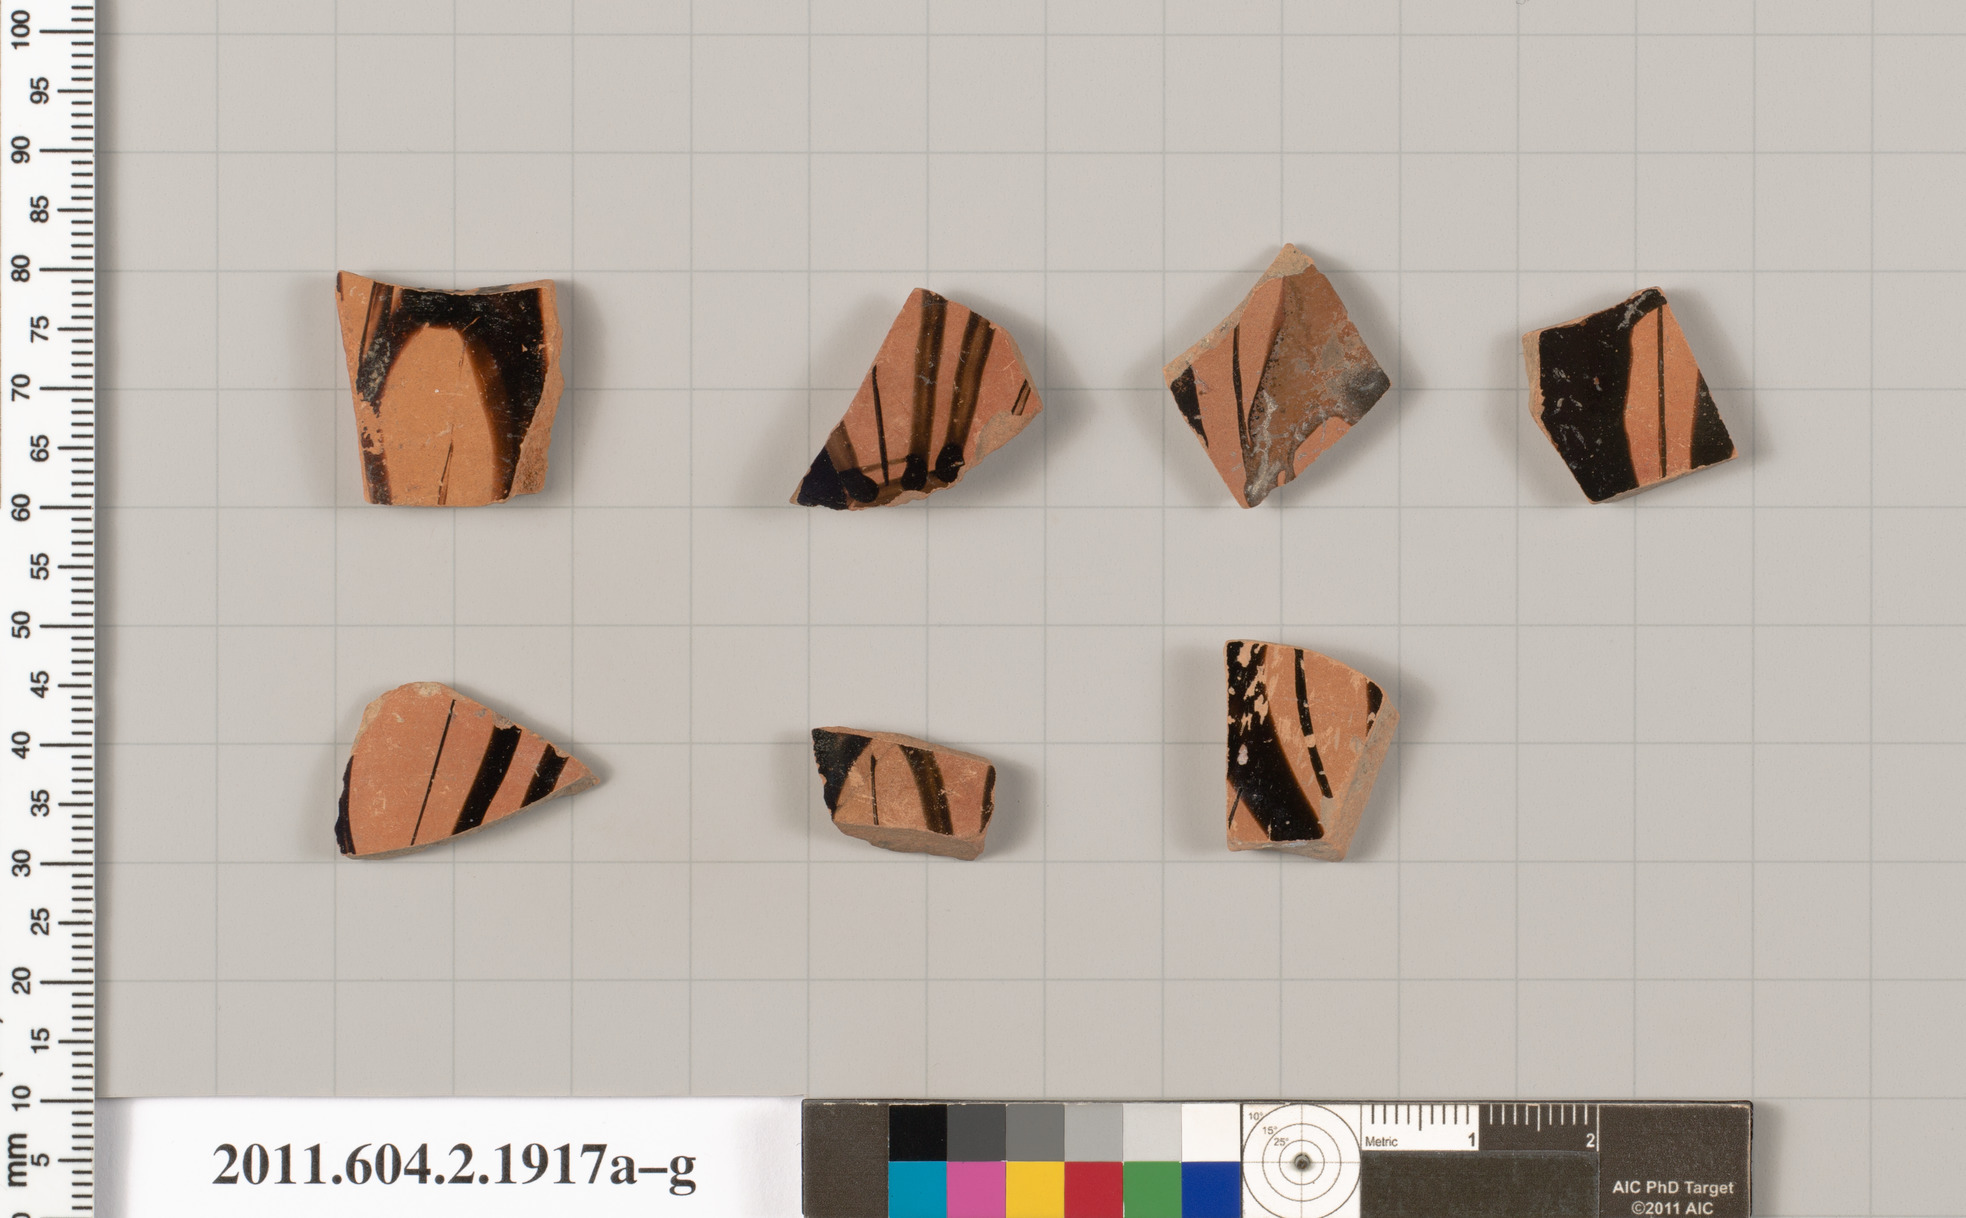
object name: skyphos fragment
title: Terracotta fragments of skyphoi (deep drinking cups)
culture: greek, attic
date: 460-430 BCE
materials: terracotta